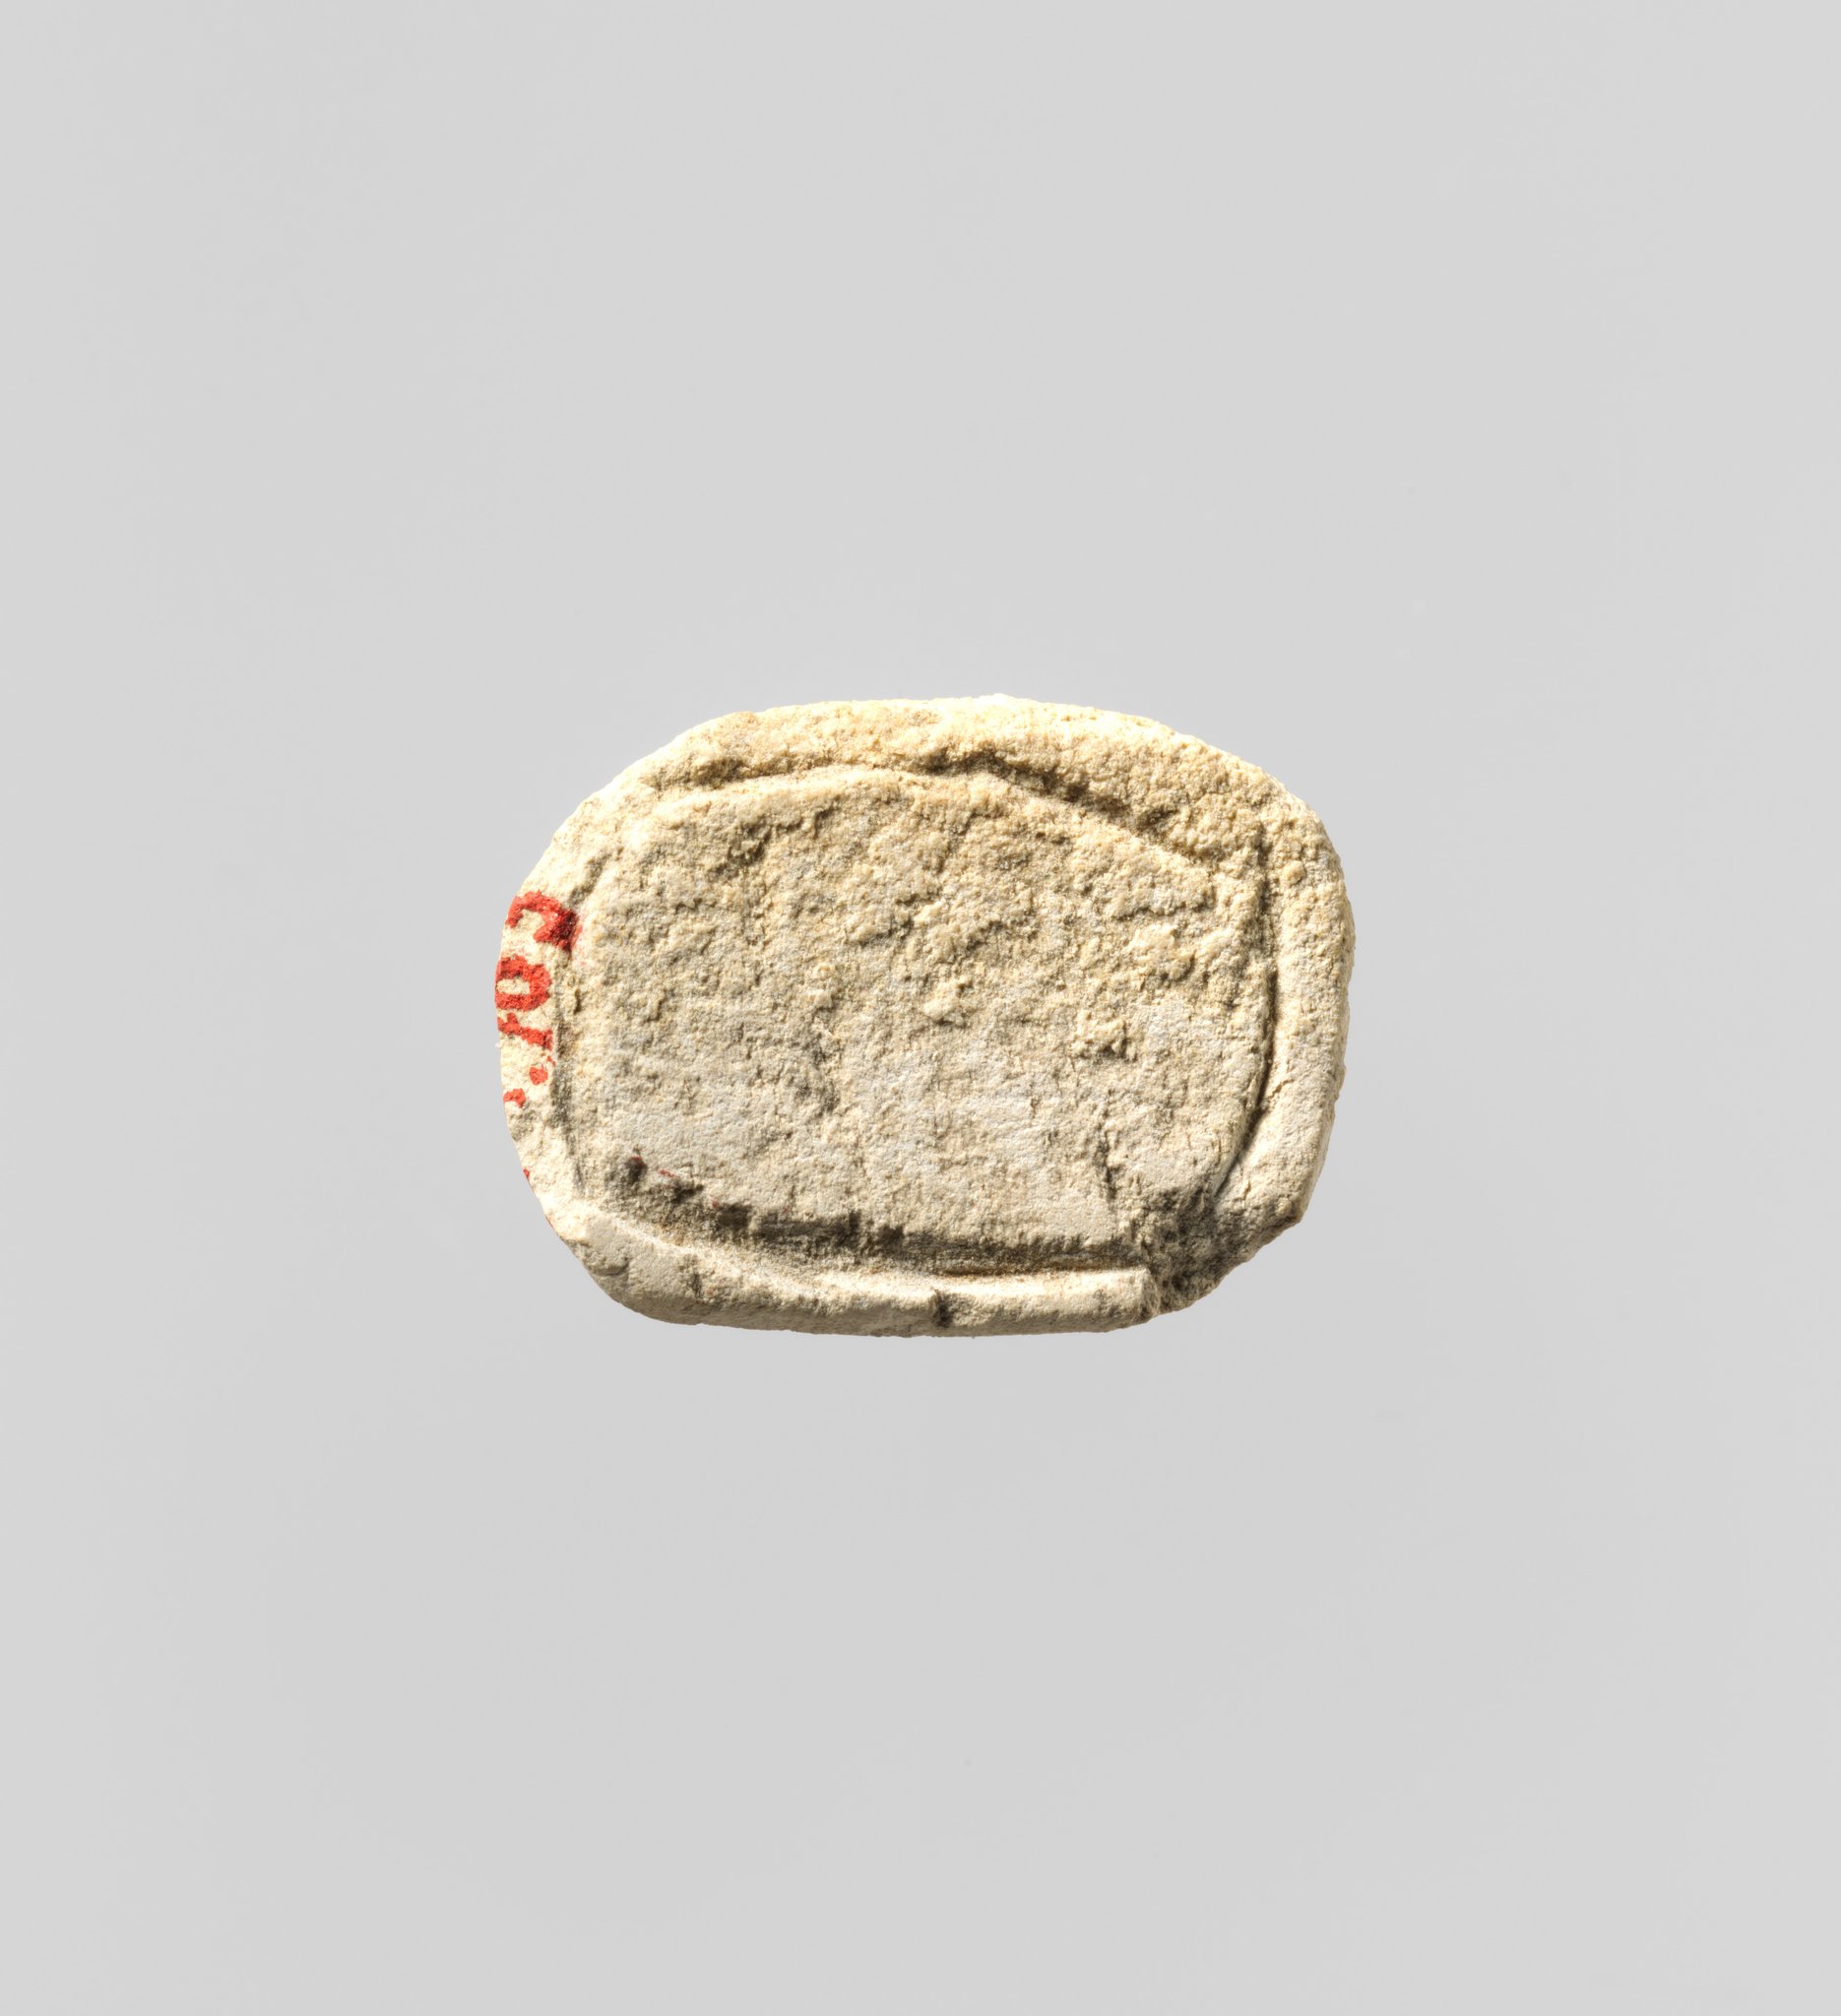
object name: stamp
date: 1295-1070 BCE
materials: limestone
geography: egypt